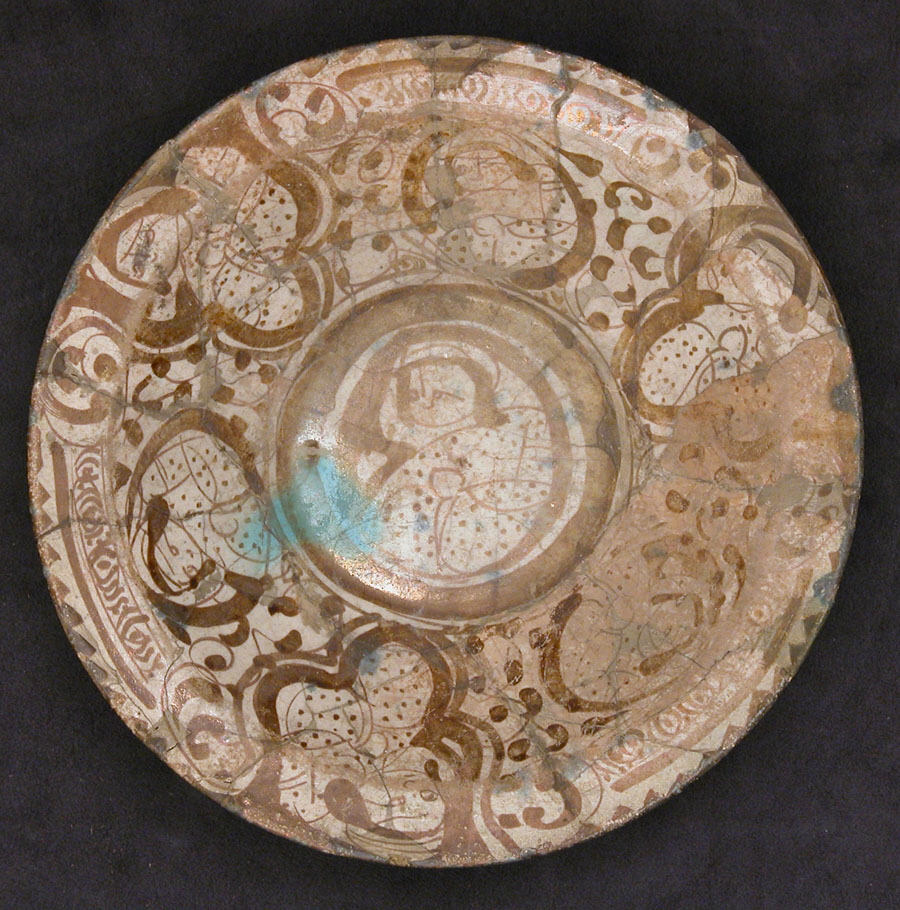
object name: dish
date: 1101-1300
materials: stonepaste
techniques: luster painting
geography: iran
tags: human figures